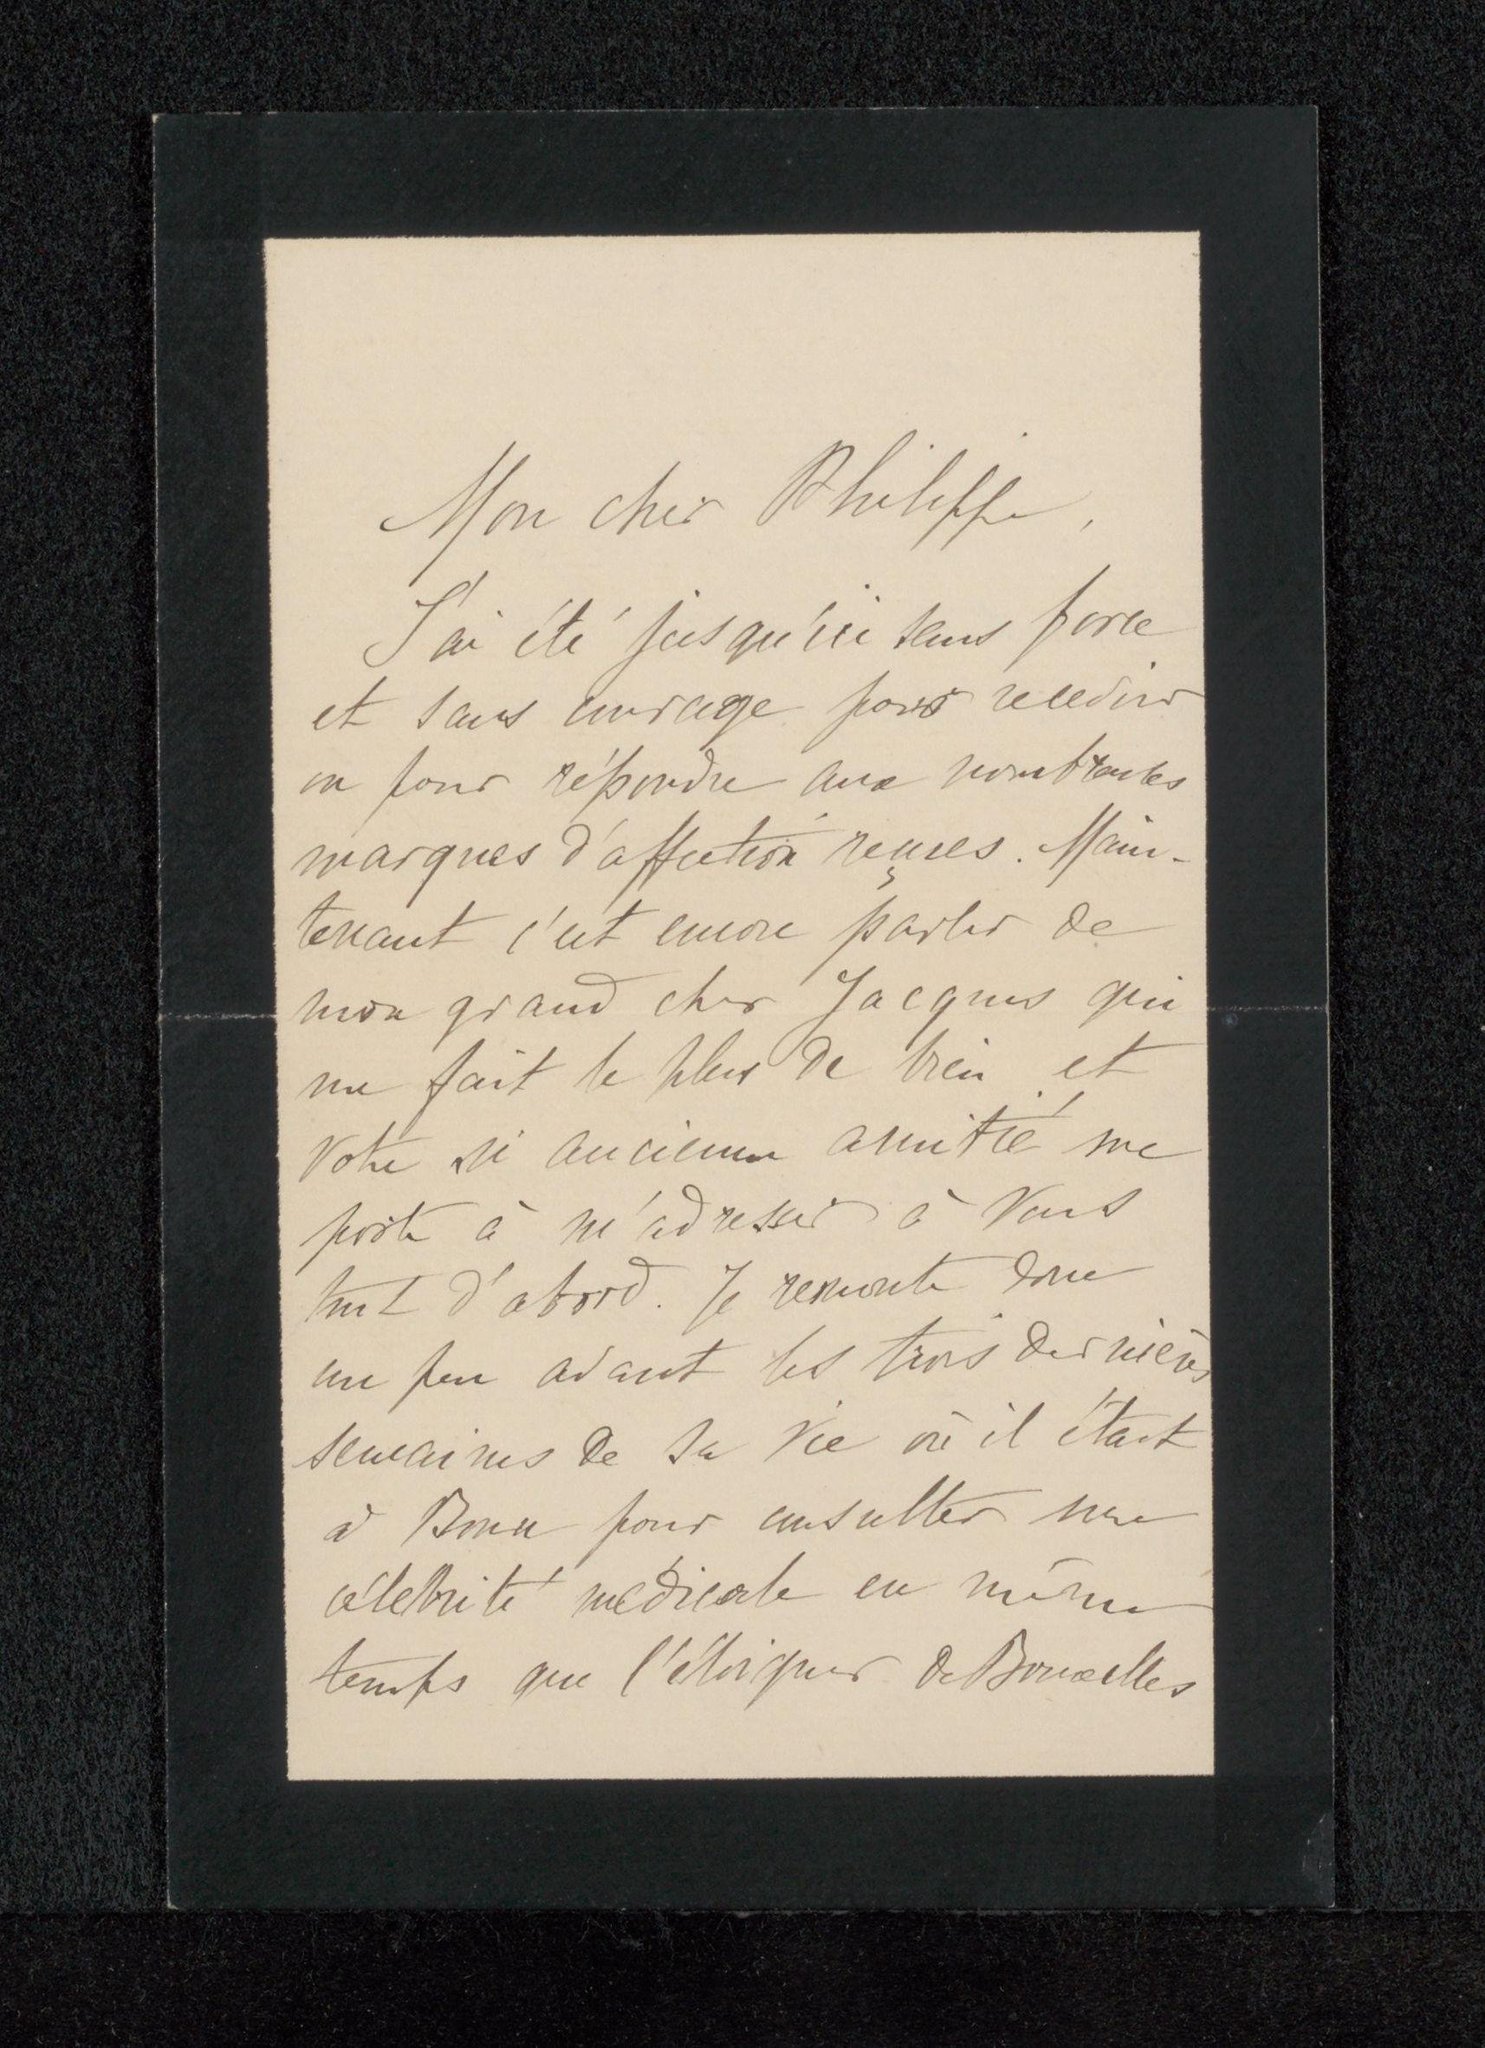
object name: letter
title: Brief aan Philip Zilcken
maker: jeanne boels de buck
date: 1912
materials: ink, paper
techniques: pen, writing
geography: brussels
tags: painter, draughtsman, philip zilcken, brussels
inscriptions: collector's mark: ‘RPK’